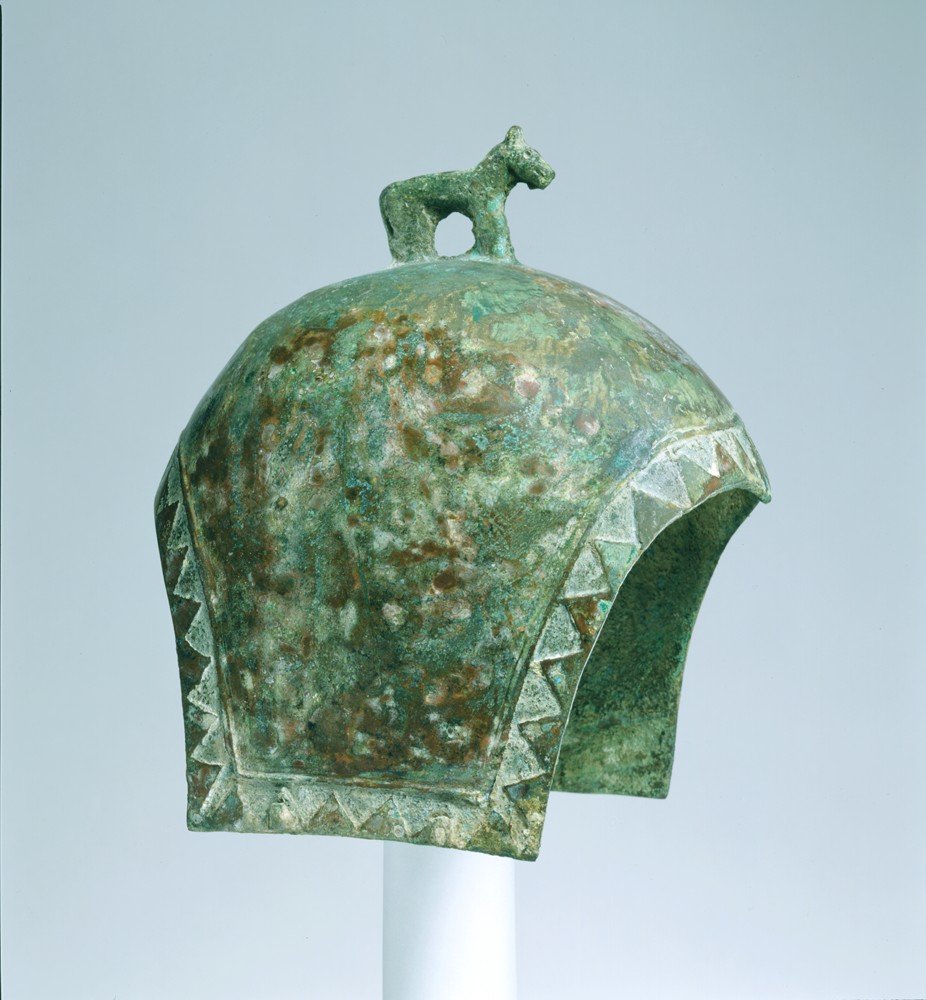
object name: helmet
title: Helmet with a Standing Horse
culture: chinese, northeast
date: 700-601 BCE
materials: bronze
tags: helmets,horses